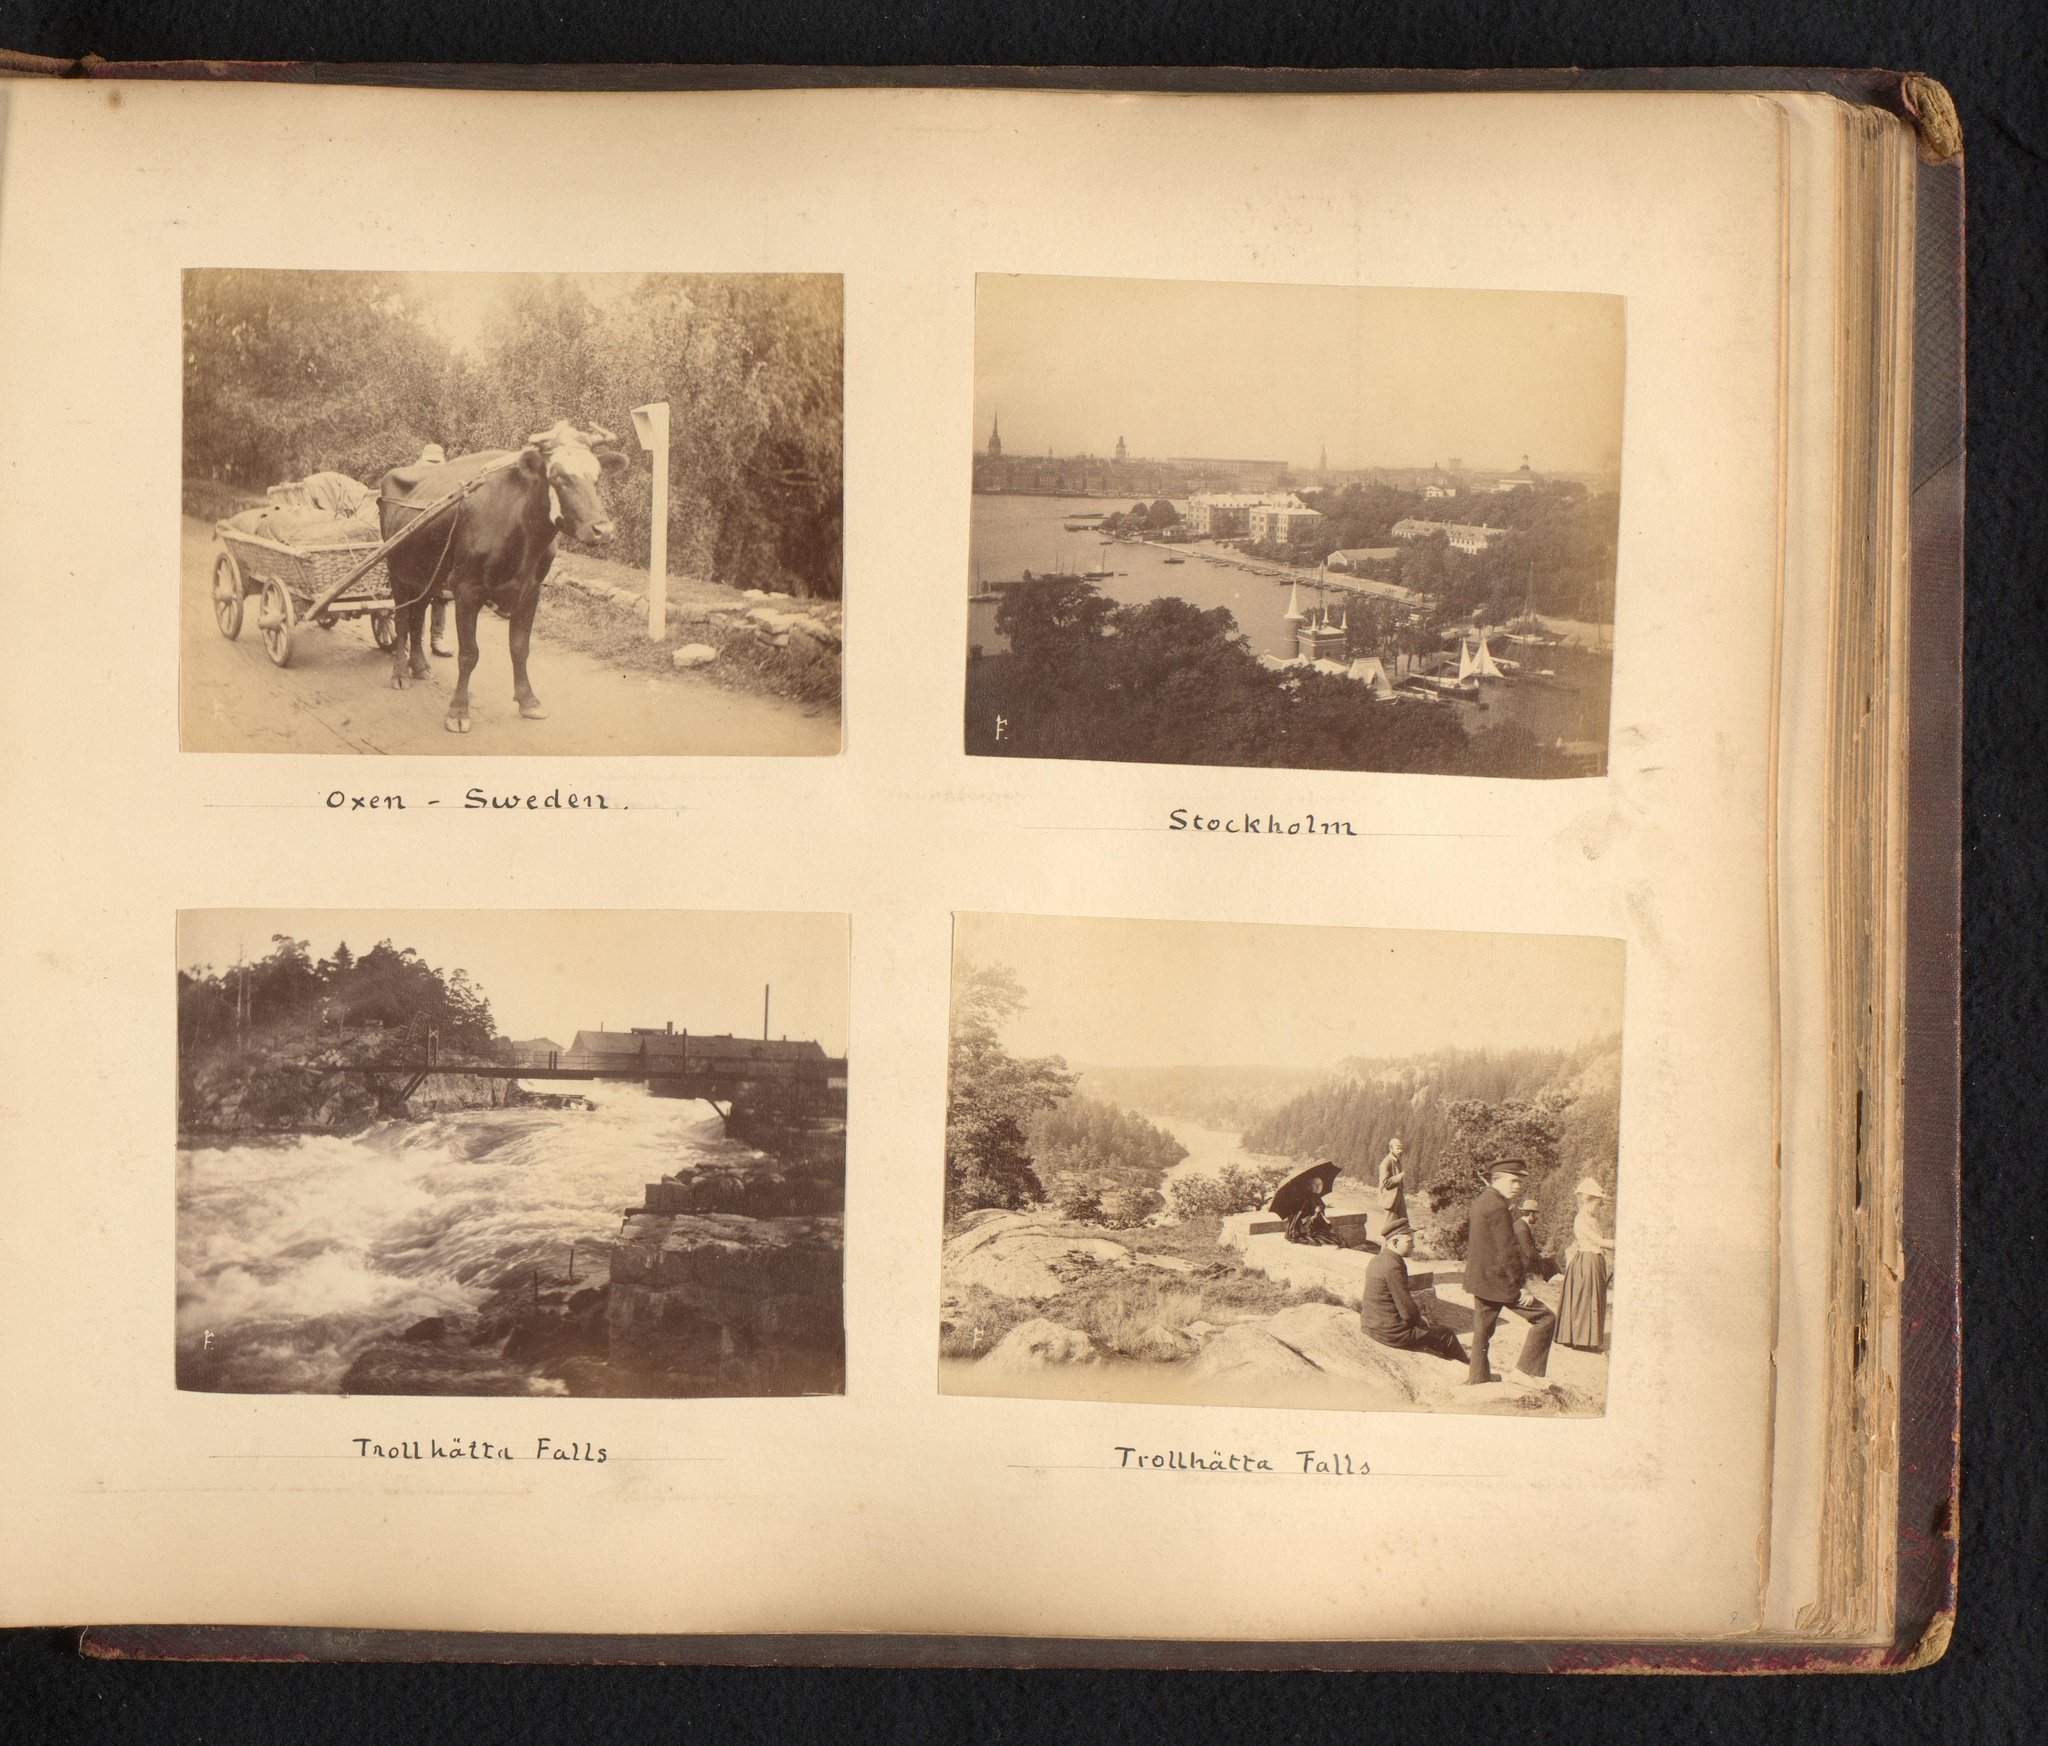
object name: album leaf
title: Gezichten op plaatsen in Zweden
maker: Anonymous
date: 1880-1897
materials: photographic support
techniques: albumen print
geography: sweden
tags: four-wheeled vehicle drawn by one animal, city-view in general; 'veduta', waterfall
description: Een os met een kar, gezichten op Stockholm en Trollhättefallen. Deze pagina maakt deel uit van een album.